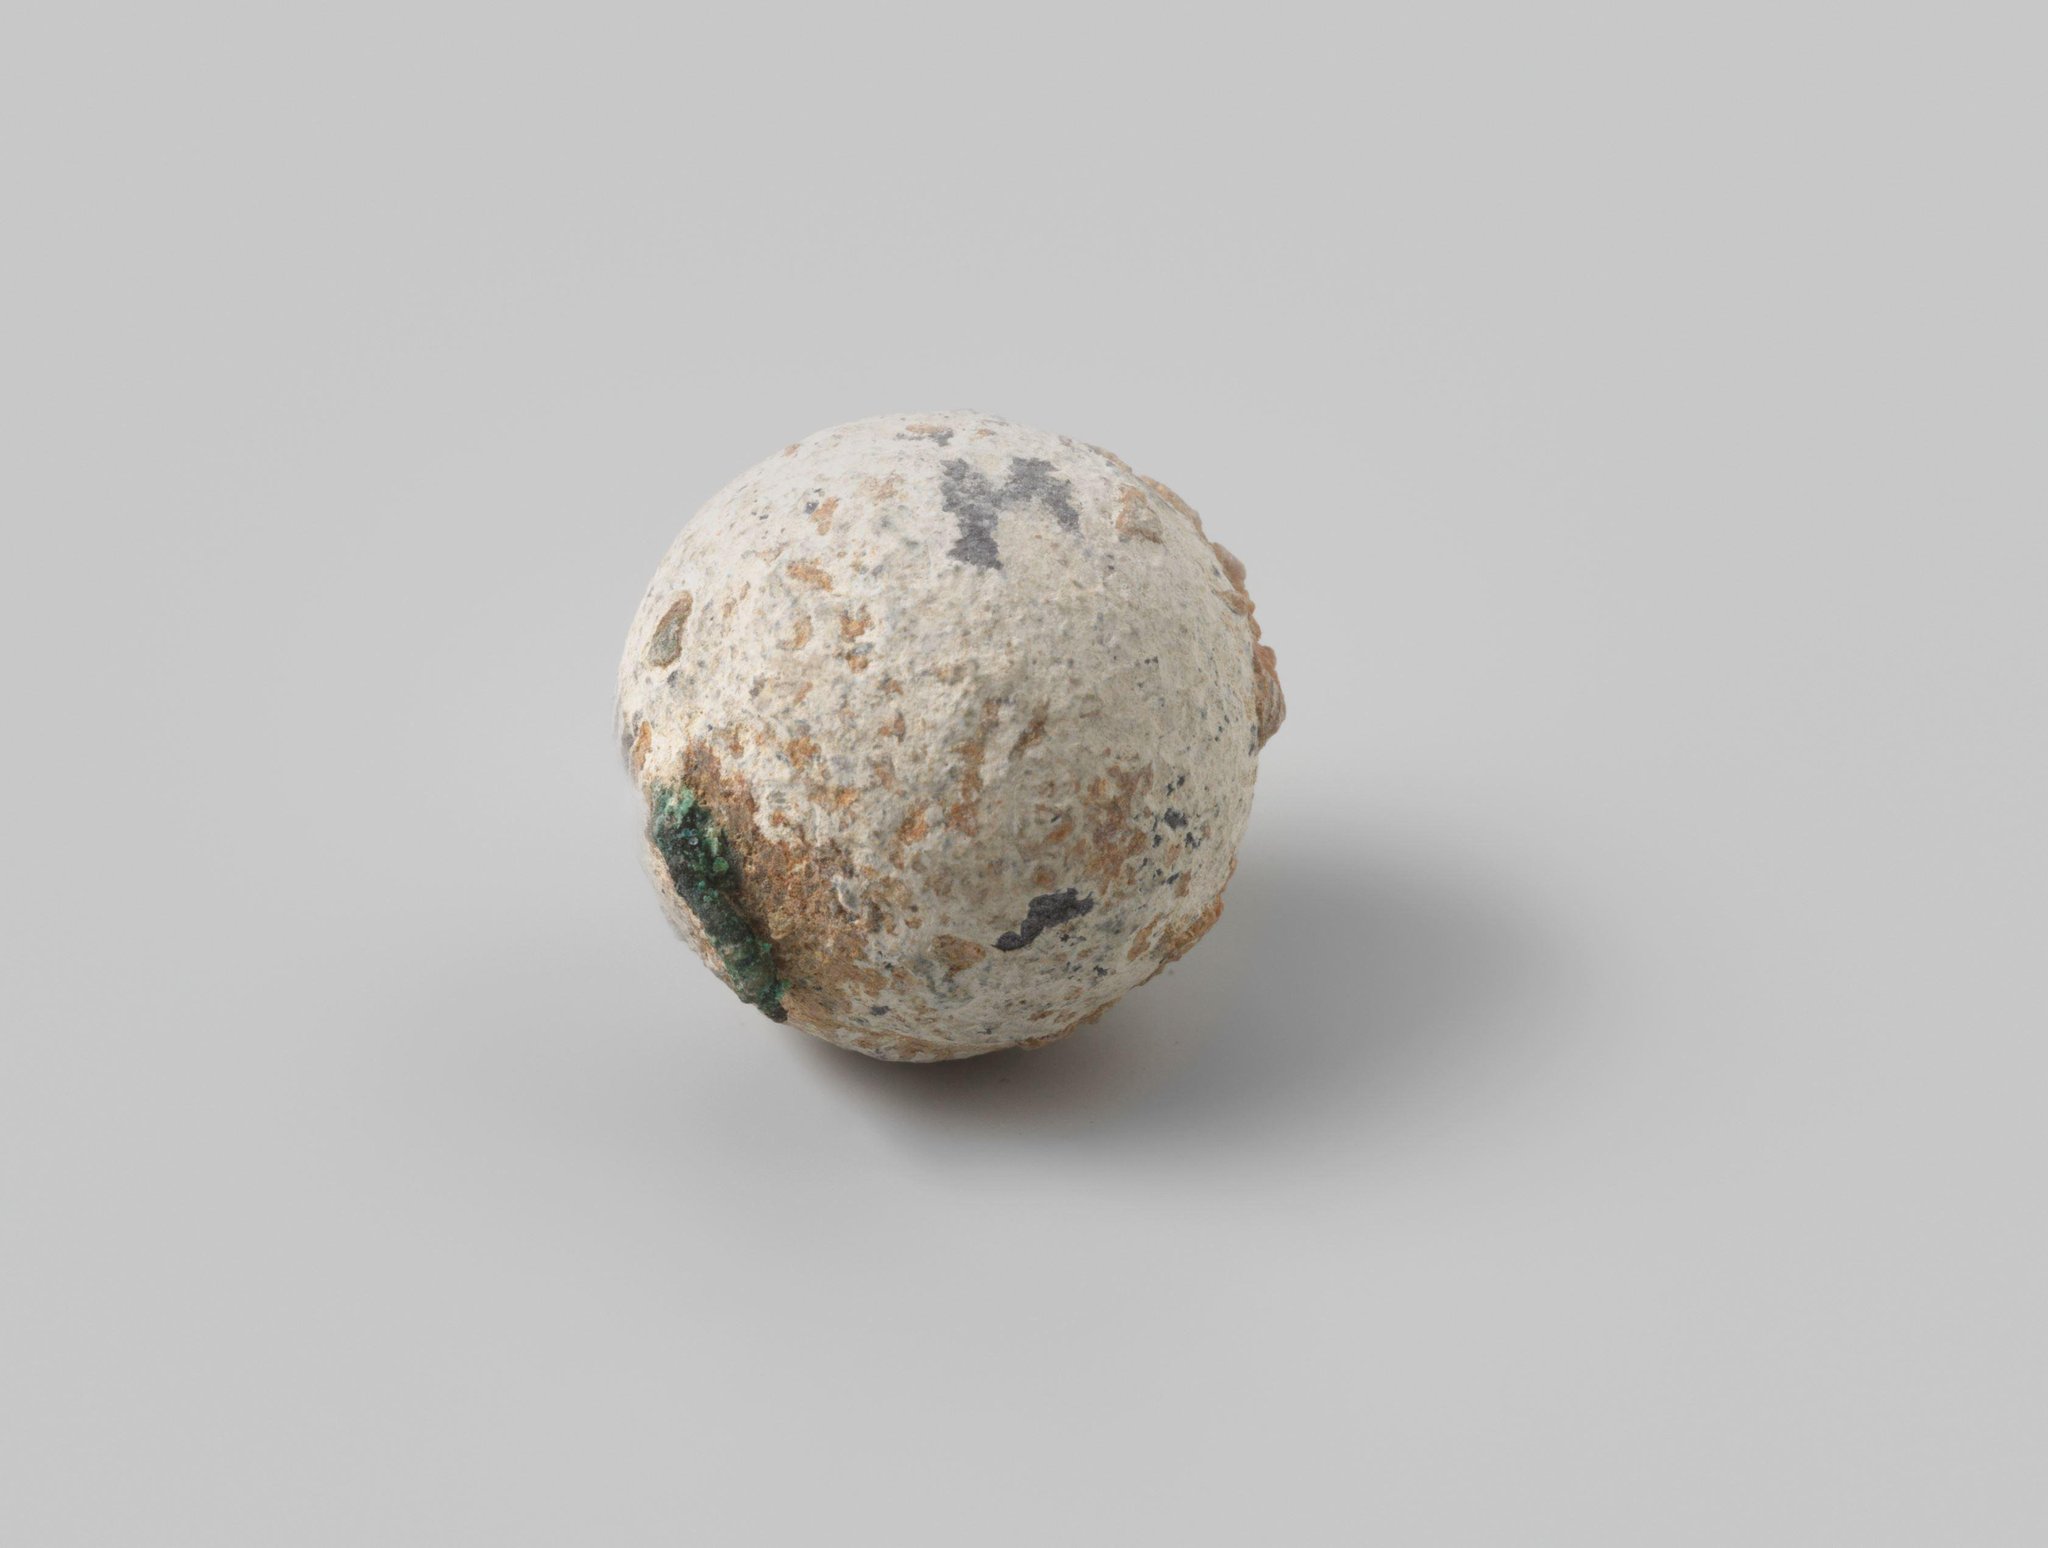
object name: chain shot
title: Kettingkogel uit het wrak van de Oost-Indiëvaarder Hollandia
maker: Anonymous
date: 1700-1743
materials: lead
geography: netherlands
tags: verenigde oostindische compagnie, hollandia (schip), annet